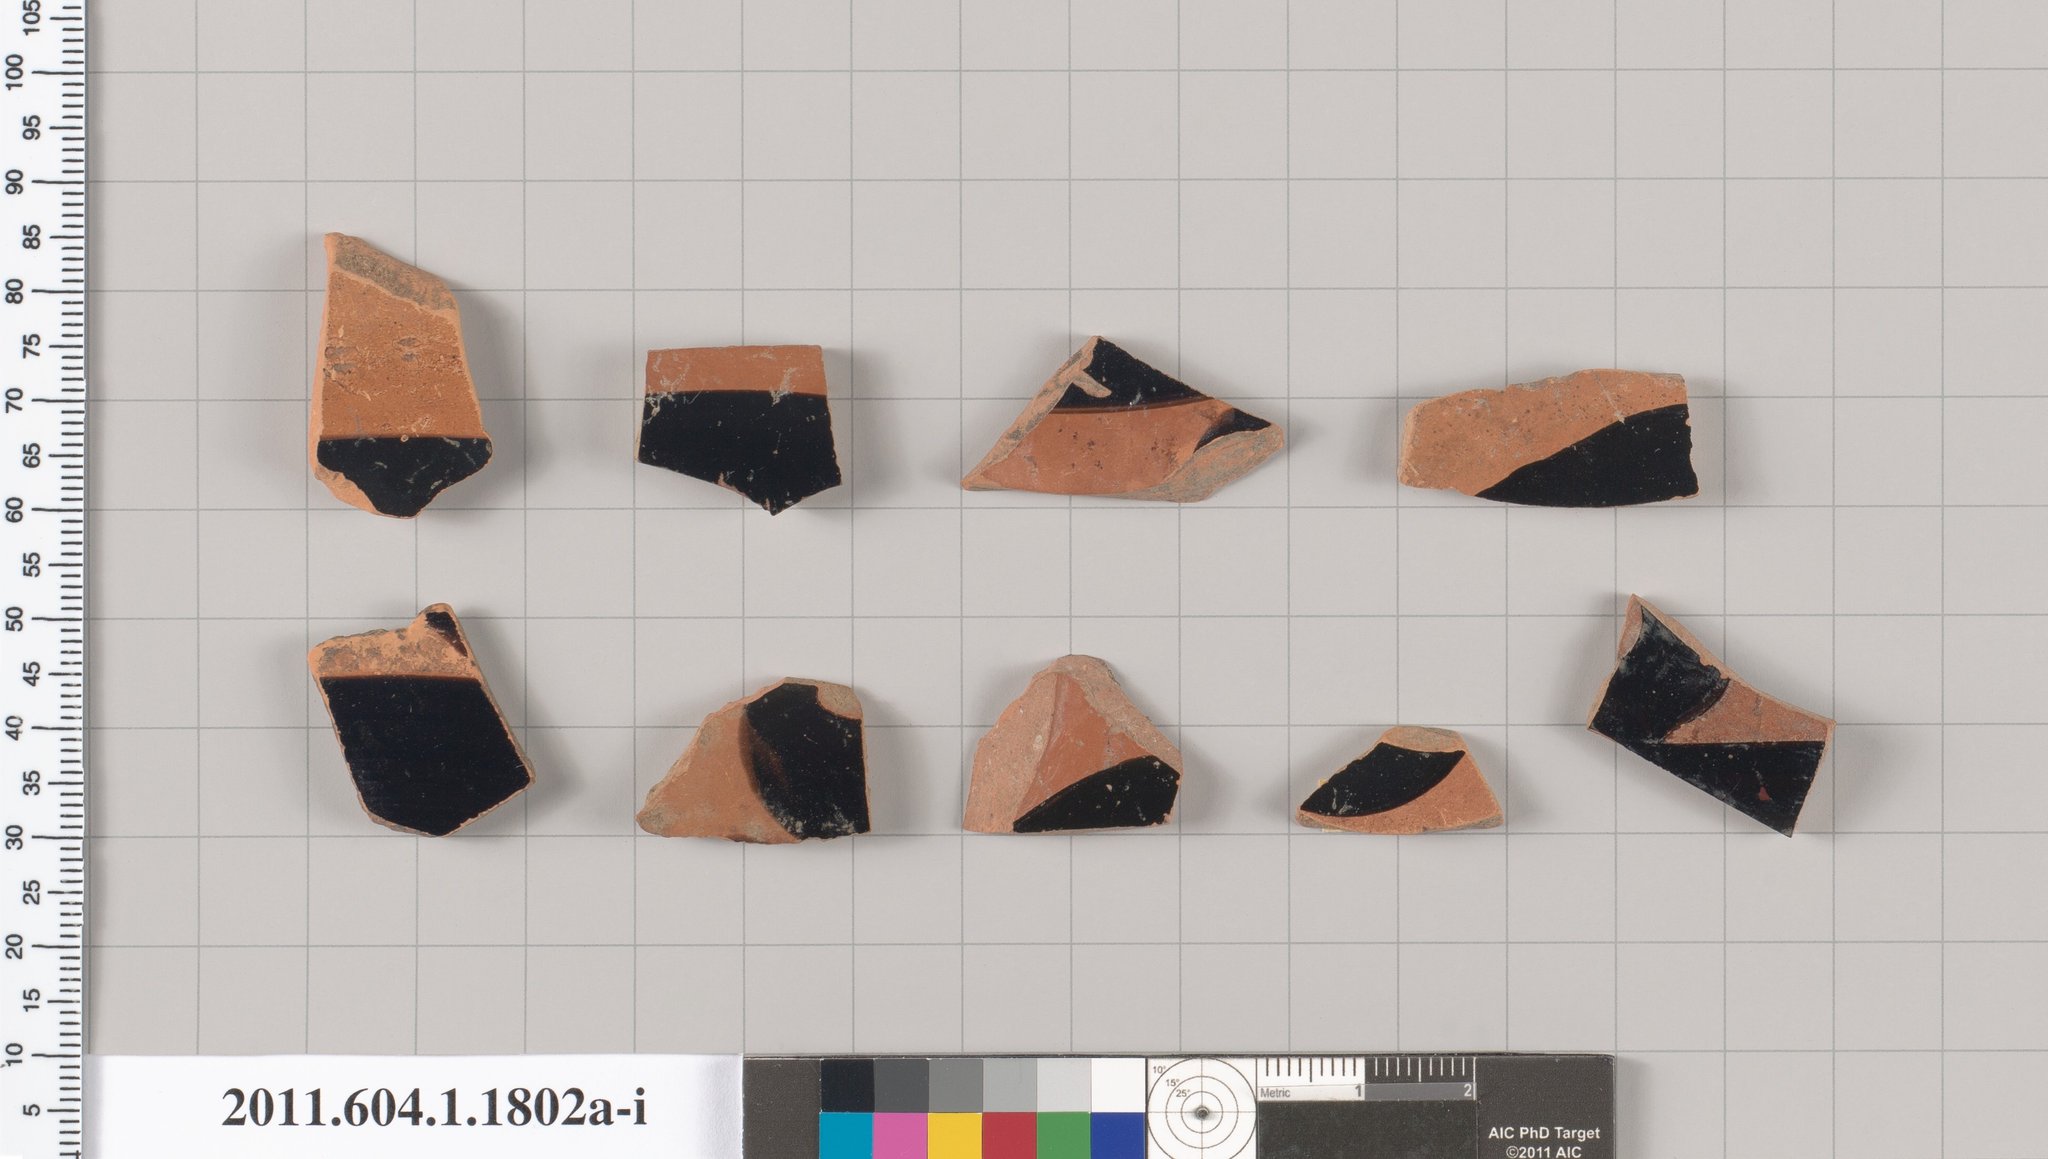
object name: kylix fragment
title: Terracotta rim fragments of kylikes(drinking cups)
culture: greek, attic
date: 500-401 BCE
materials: terracotta